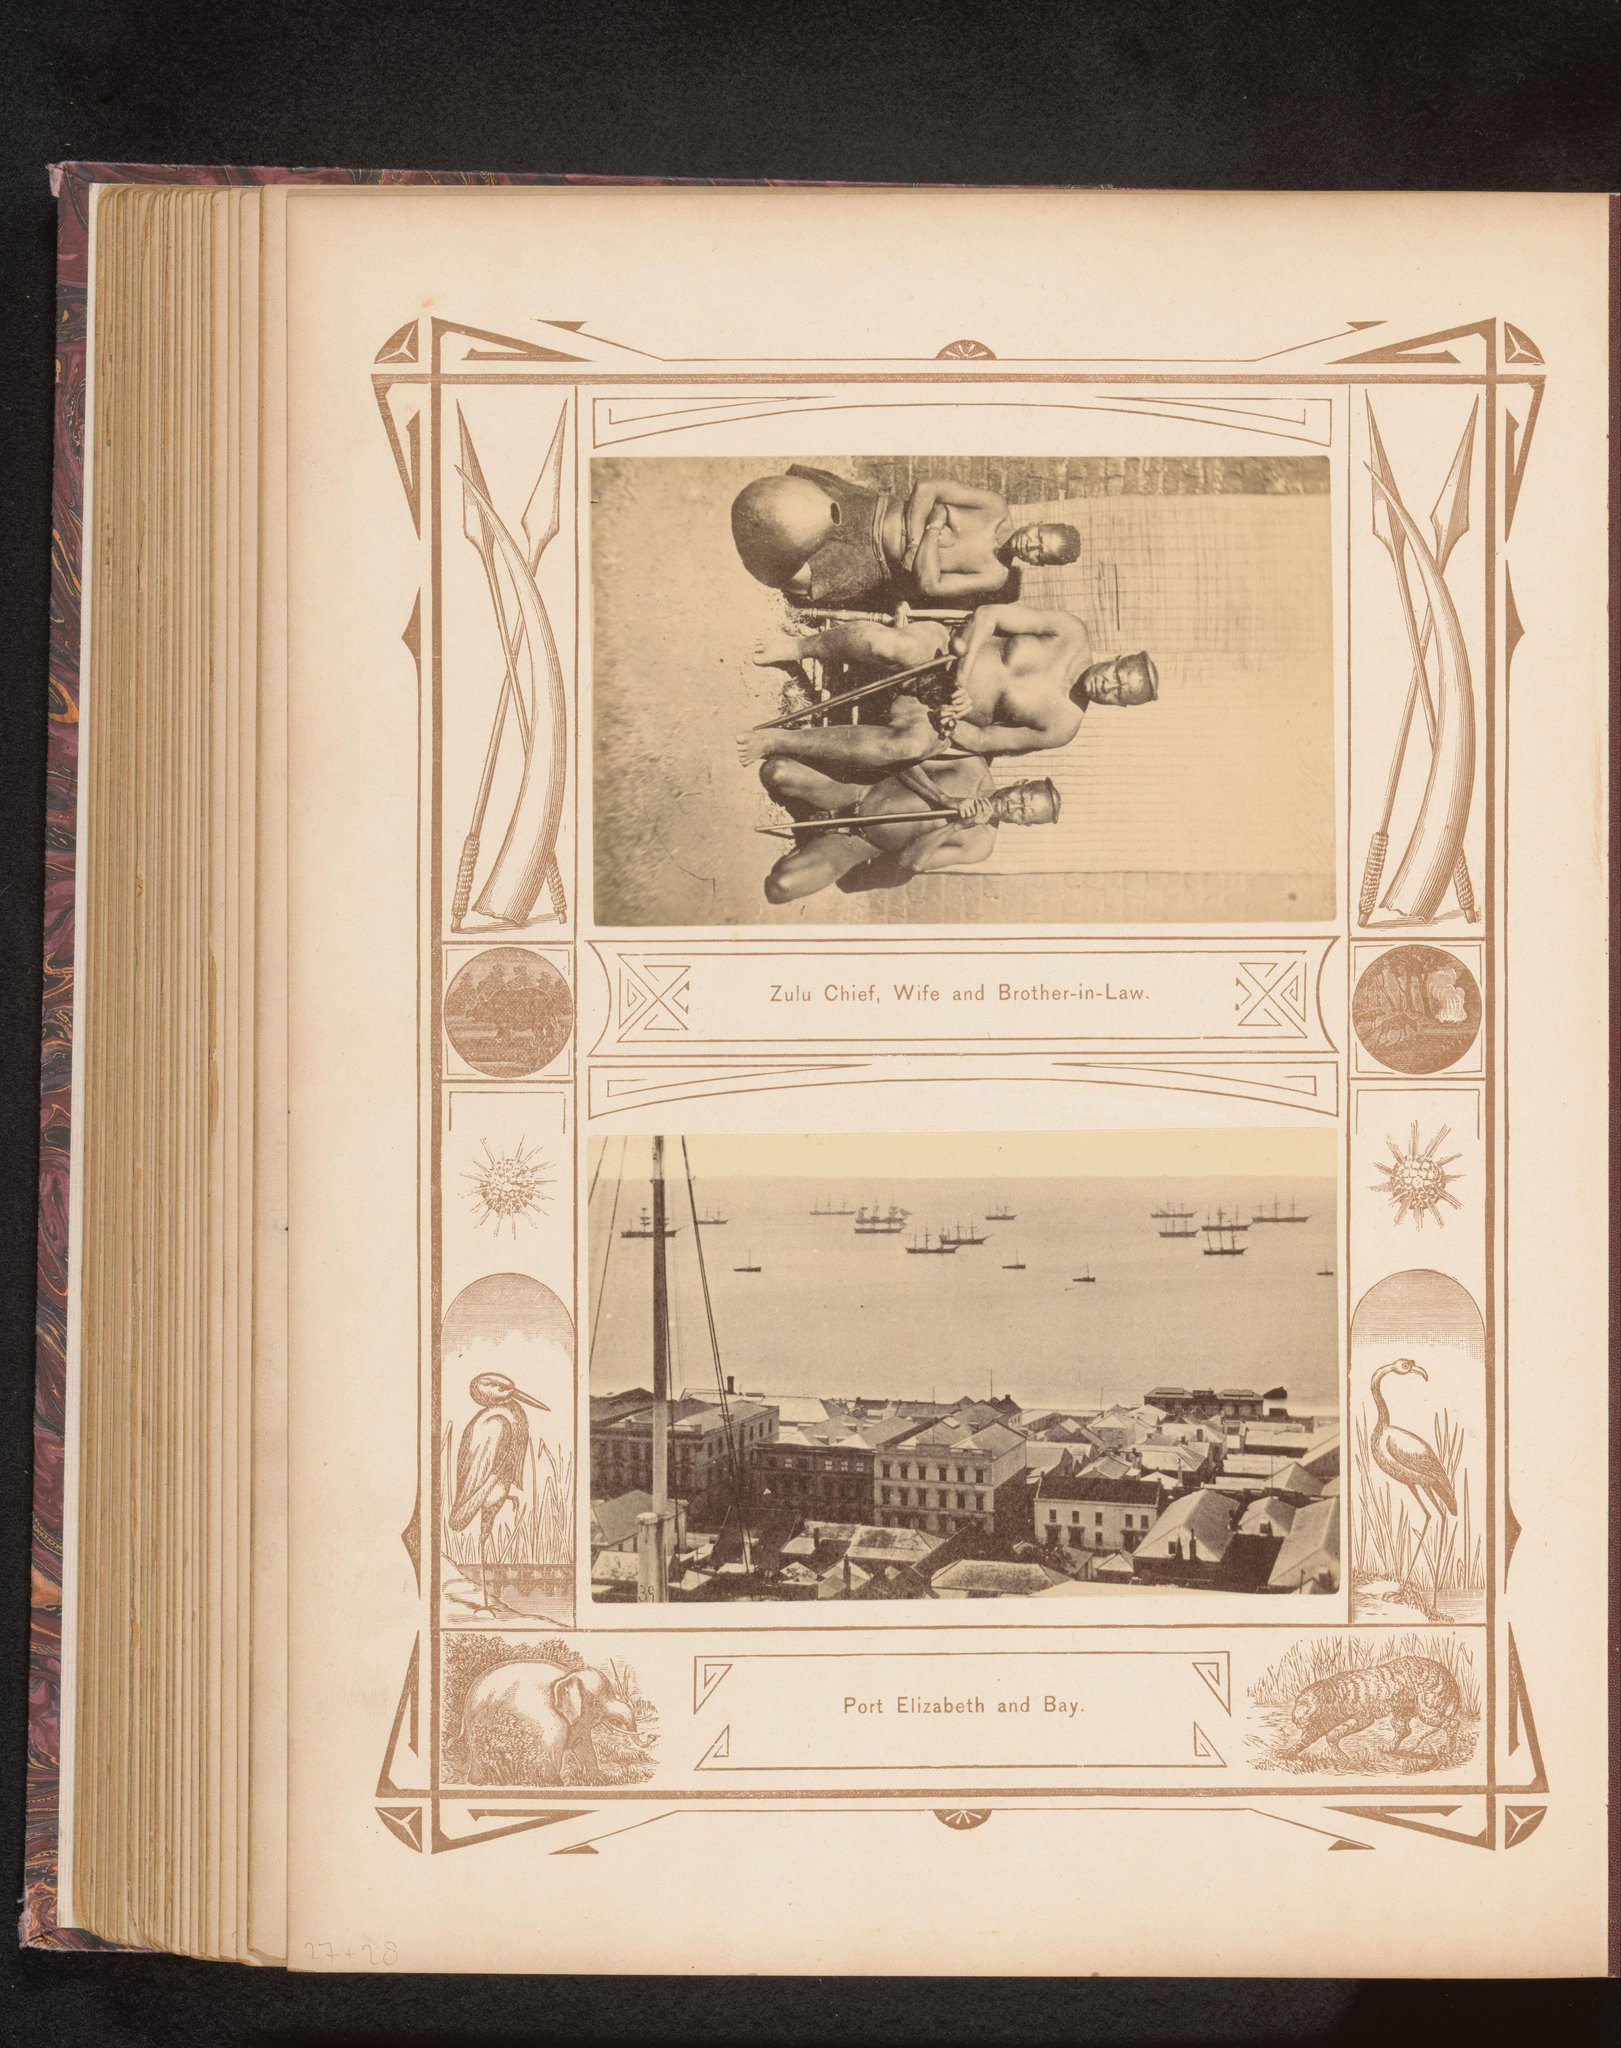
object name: photograph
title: Zoeloe leider met zijn vrouw en zijn zwager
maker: Anonymous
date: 1877-1882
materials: photographic support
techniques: albumen print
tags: adult woman, africans, adult man, historical persons